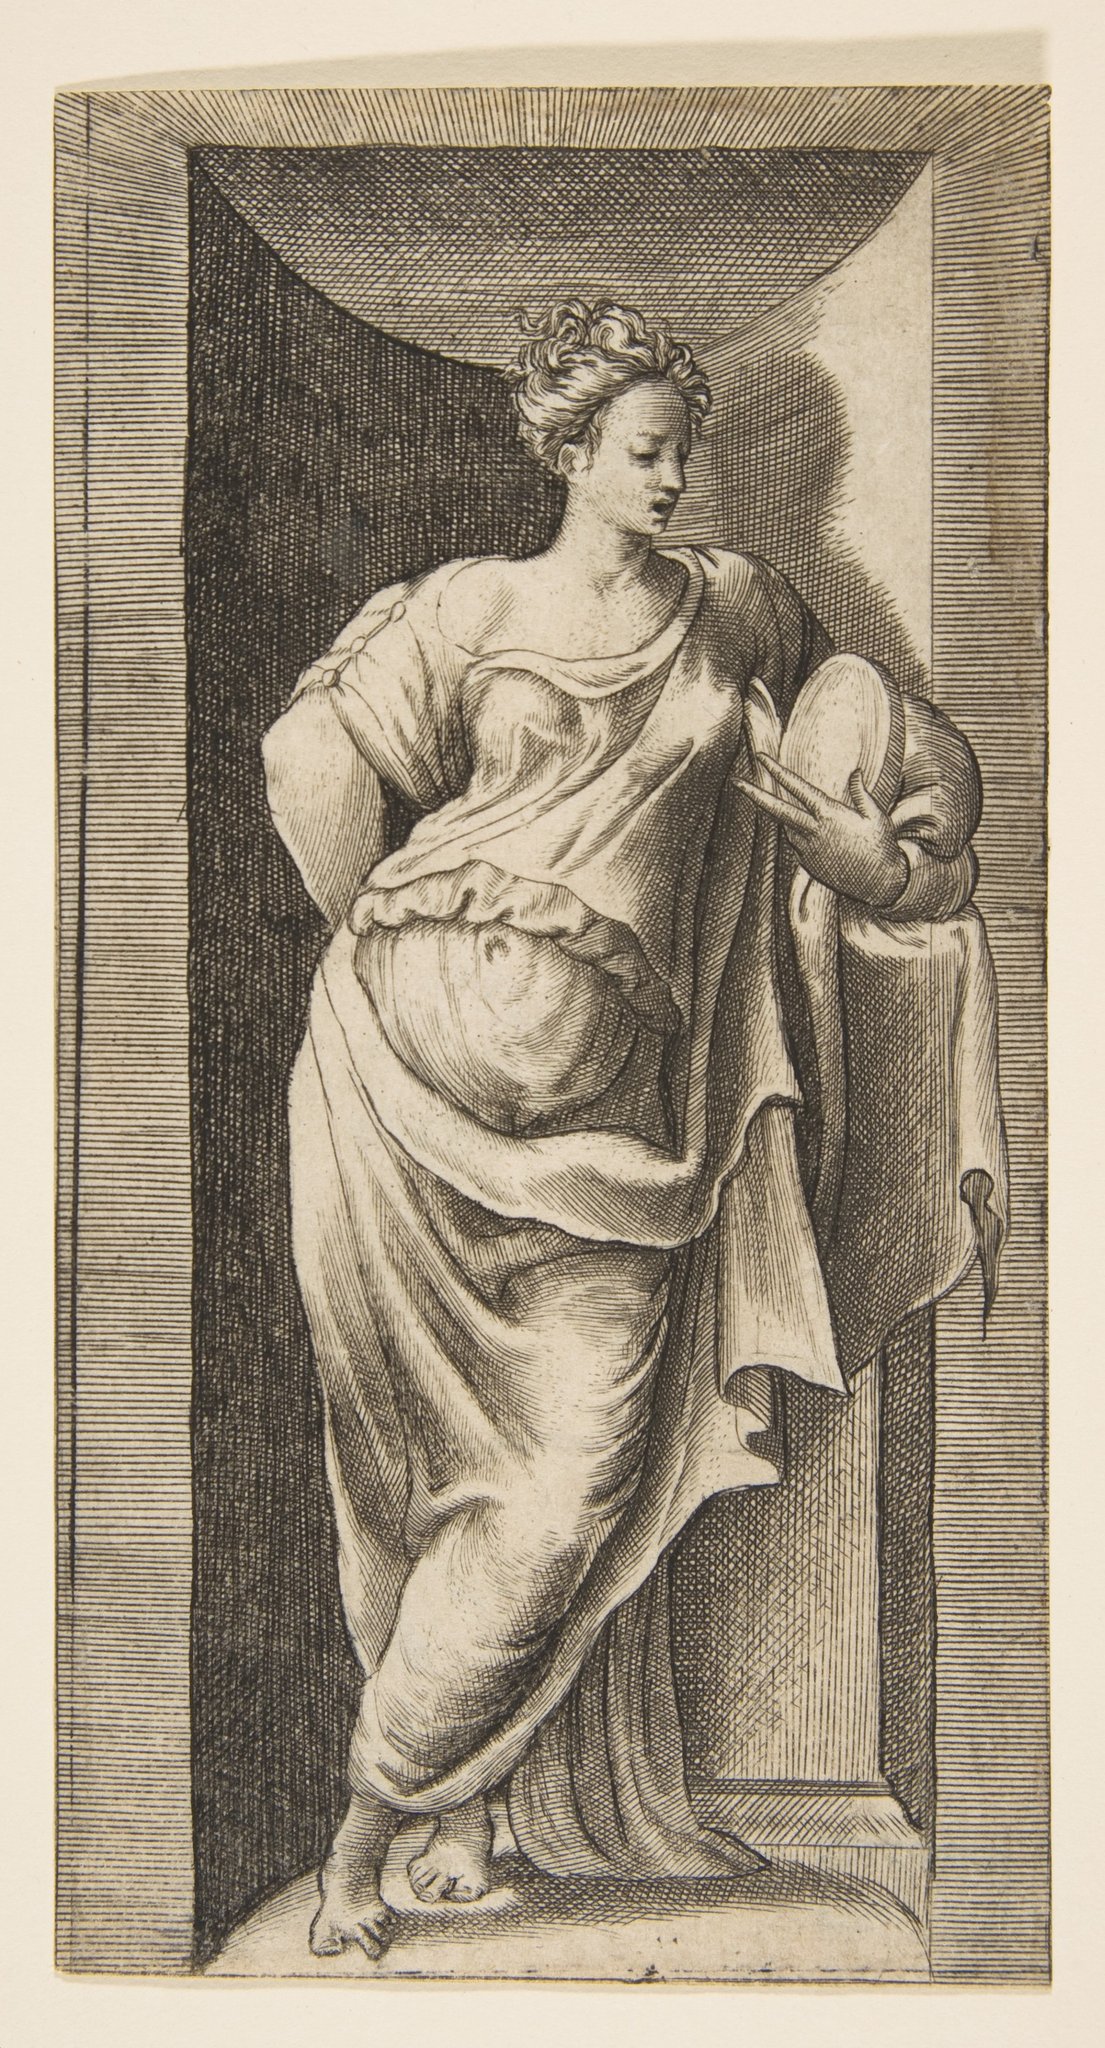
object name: print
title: A muse standing in a niche, left arm resting in a ledge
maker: giulio bonasone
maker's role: artist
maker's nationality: italian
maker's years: 1510-1576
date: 1531-1576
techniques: engraving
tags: muses